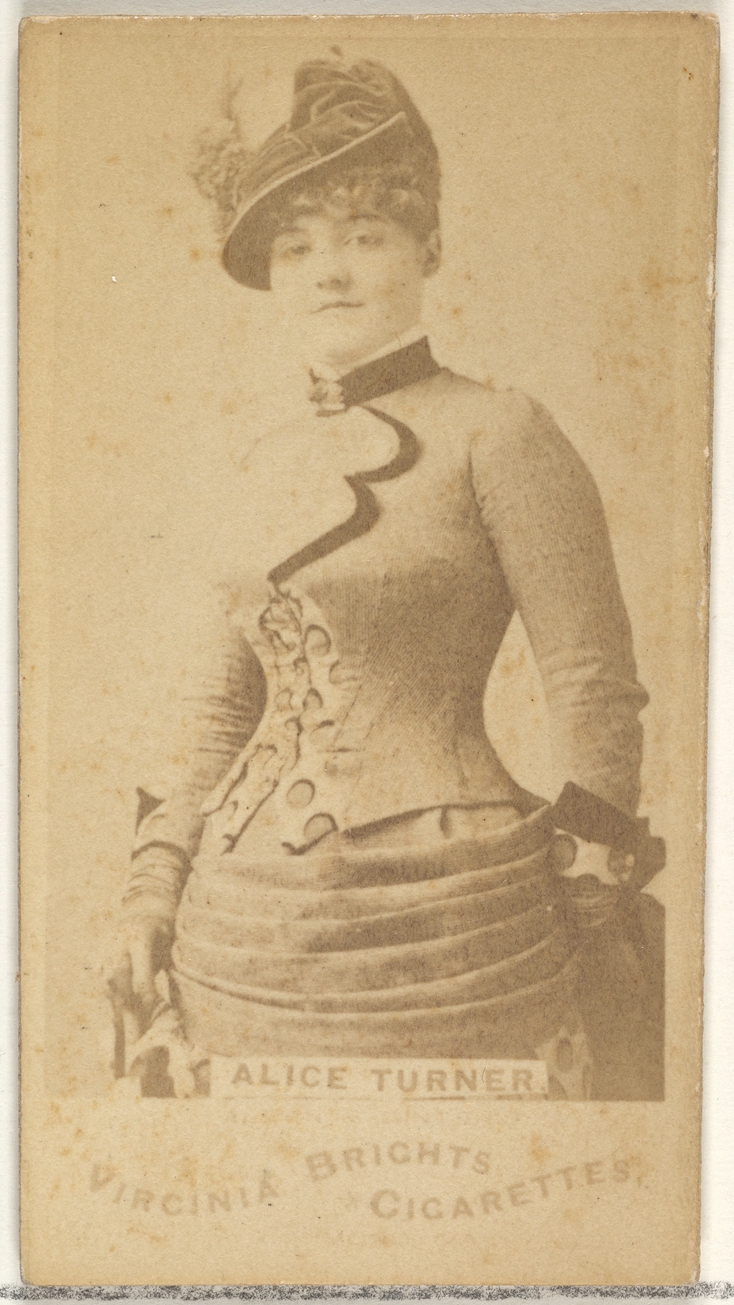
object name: photograph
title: Alice Turner, from the Actors and Actresses series (N45, Type 1) for Virginia Brights Cigarettes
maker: allen & ginter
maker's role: publisher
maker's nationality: american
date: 1888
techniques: albumen silver print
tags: portraits,women,actresses